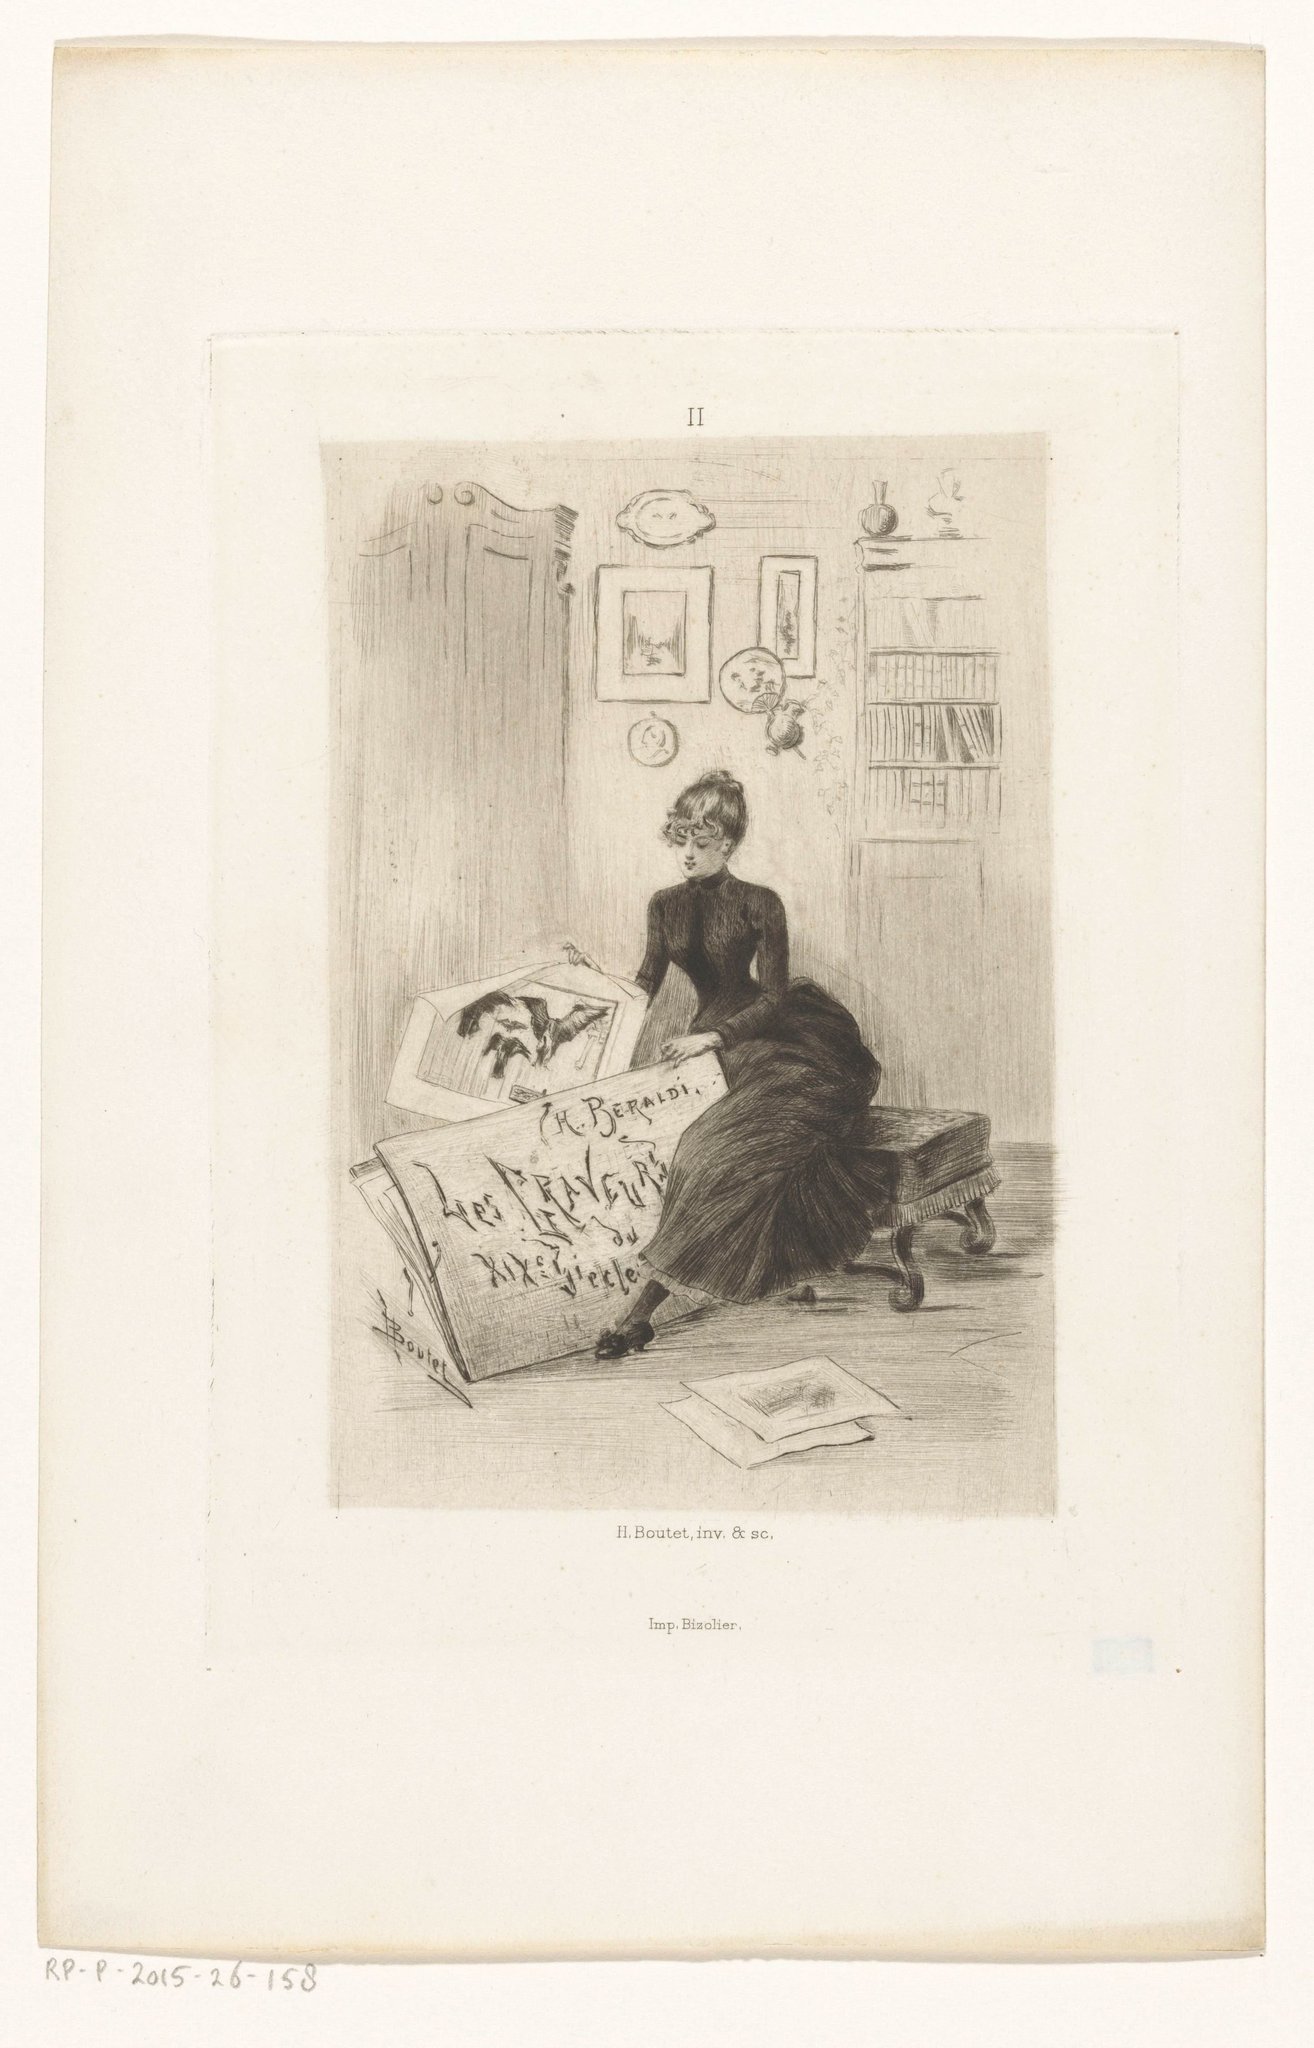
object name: print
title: Titelpagina voor: Henri Béraldi, Les graveurs du XIXe siècle, 1885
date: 1885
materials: paper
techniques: drypoint, intaglio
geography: paris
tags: print, e.g.: engraving, etching, lithograph, art collecting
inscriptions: collector's mark: Lugt 2228, collector's mark: Lugt 4779, watermark, collector's mark: Lugt 4780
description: Een vrouw op een bank in een huiselijk interieur haalt een prent uit een portfolio. Het gaat om een afdruk van Félix Bracquemond, Le Haut d'un battant de porte (1865). Boven genummerd: 2.